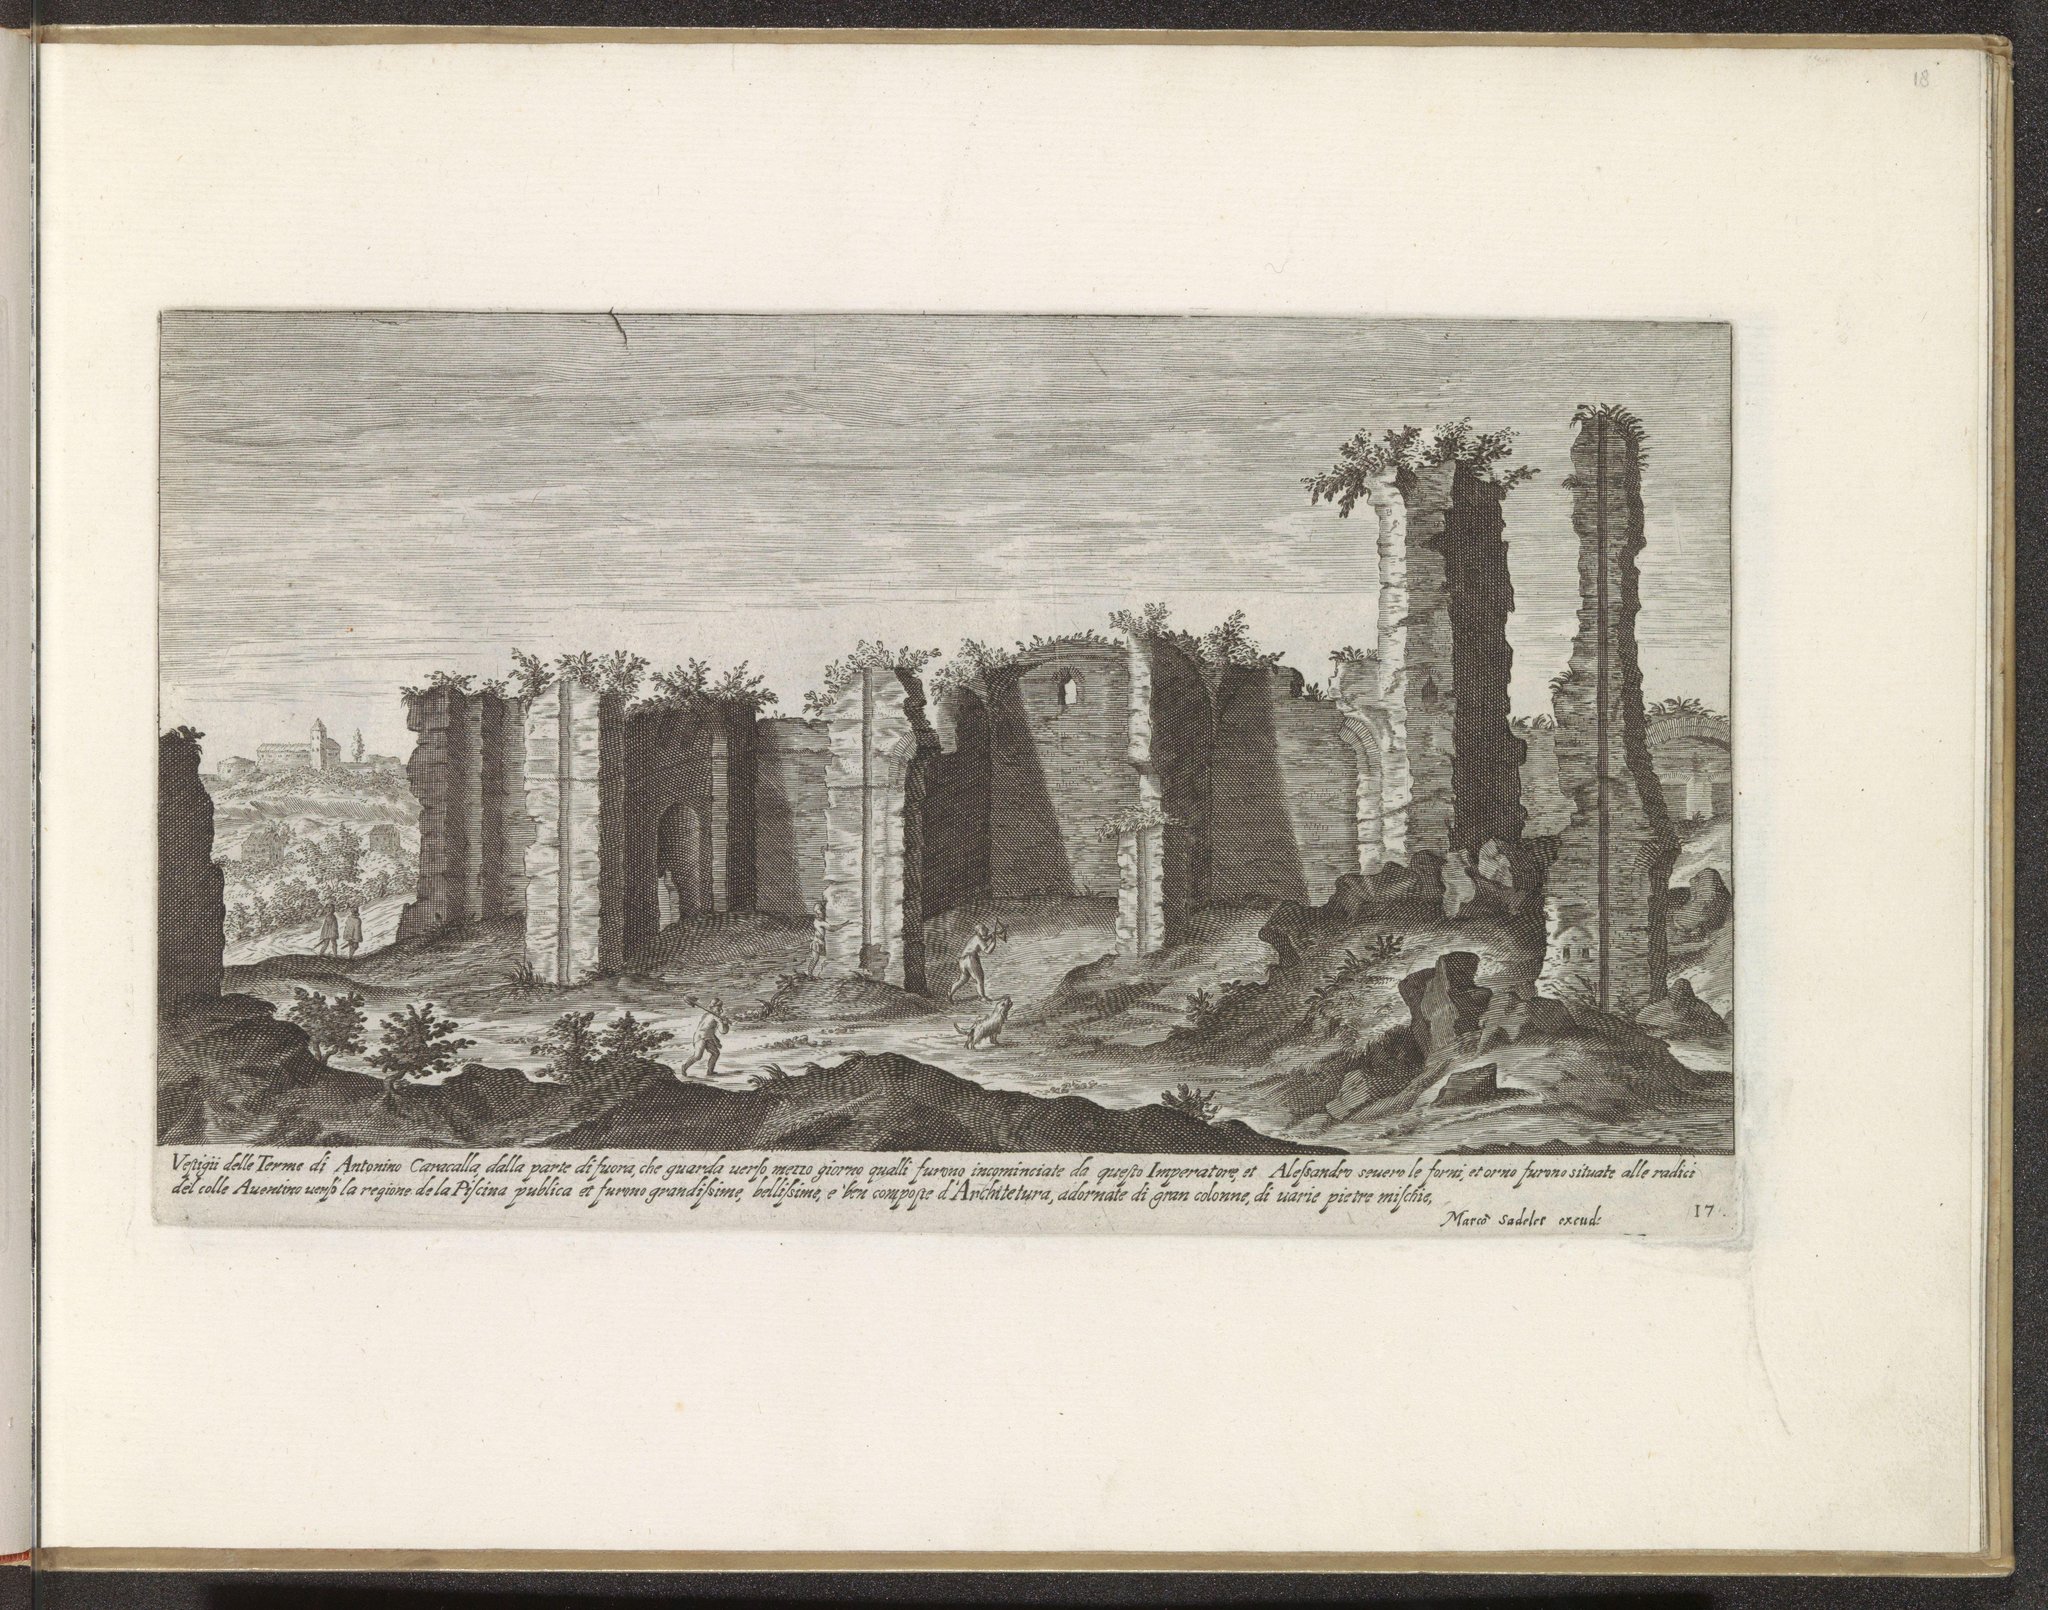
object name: album leaf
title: Thermen van Caracalla, van buiten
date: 1606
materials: paper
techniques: engraving, etching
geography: prague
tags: rome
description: Ruïnes van de Thermen van Caracalla in Rome, van buiten. Op de voorgrond onder meer een man met schep. In de ondermarge twee regels tekst in het Italiaans. De prent maakt deel uit van een album.